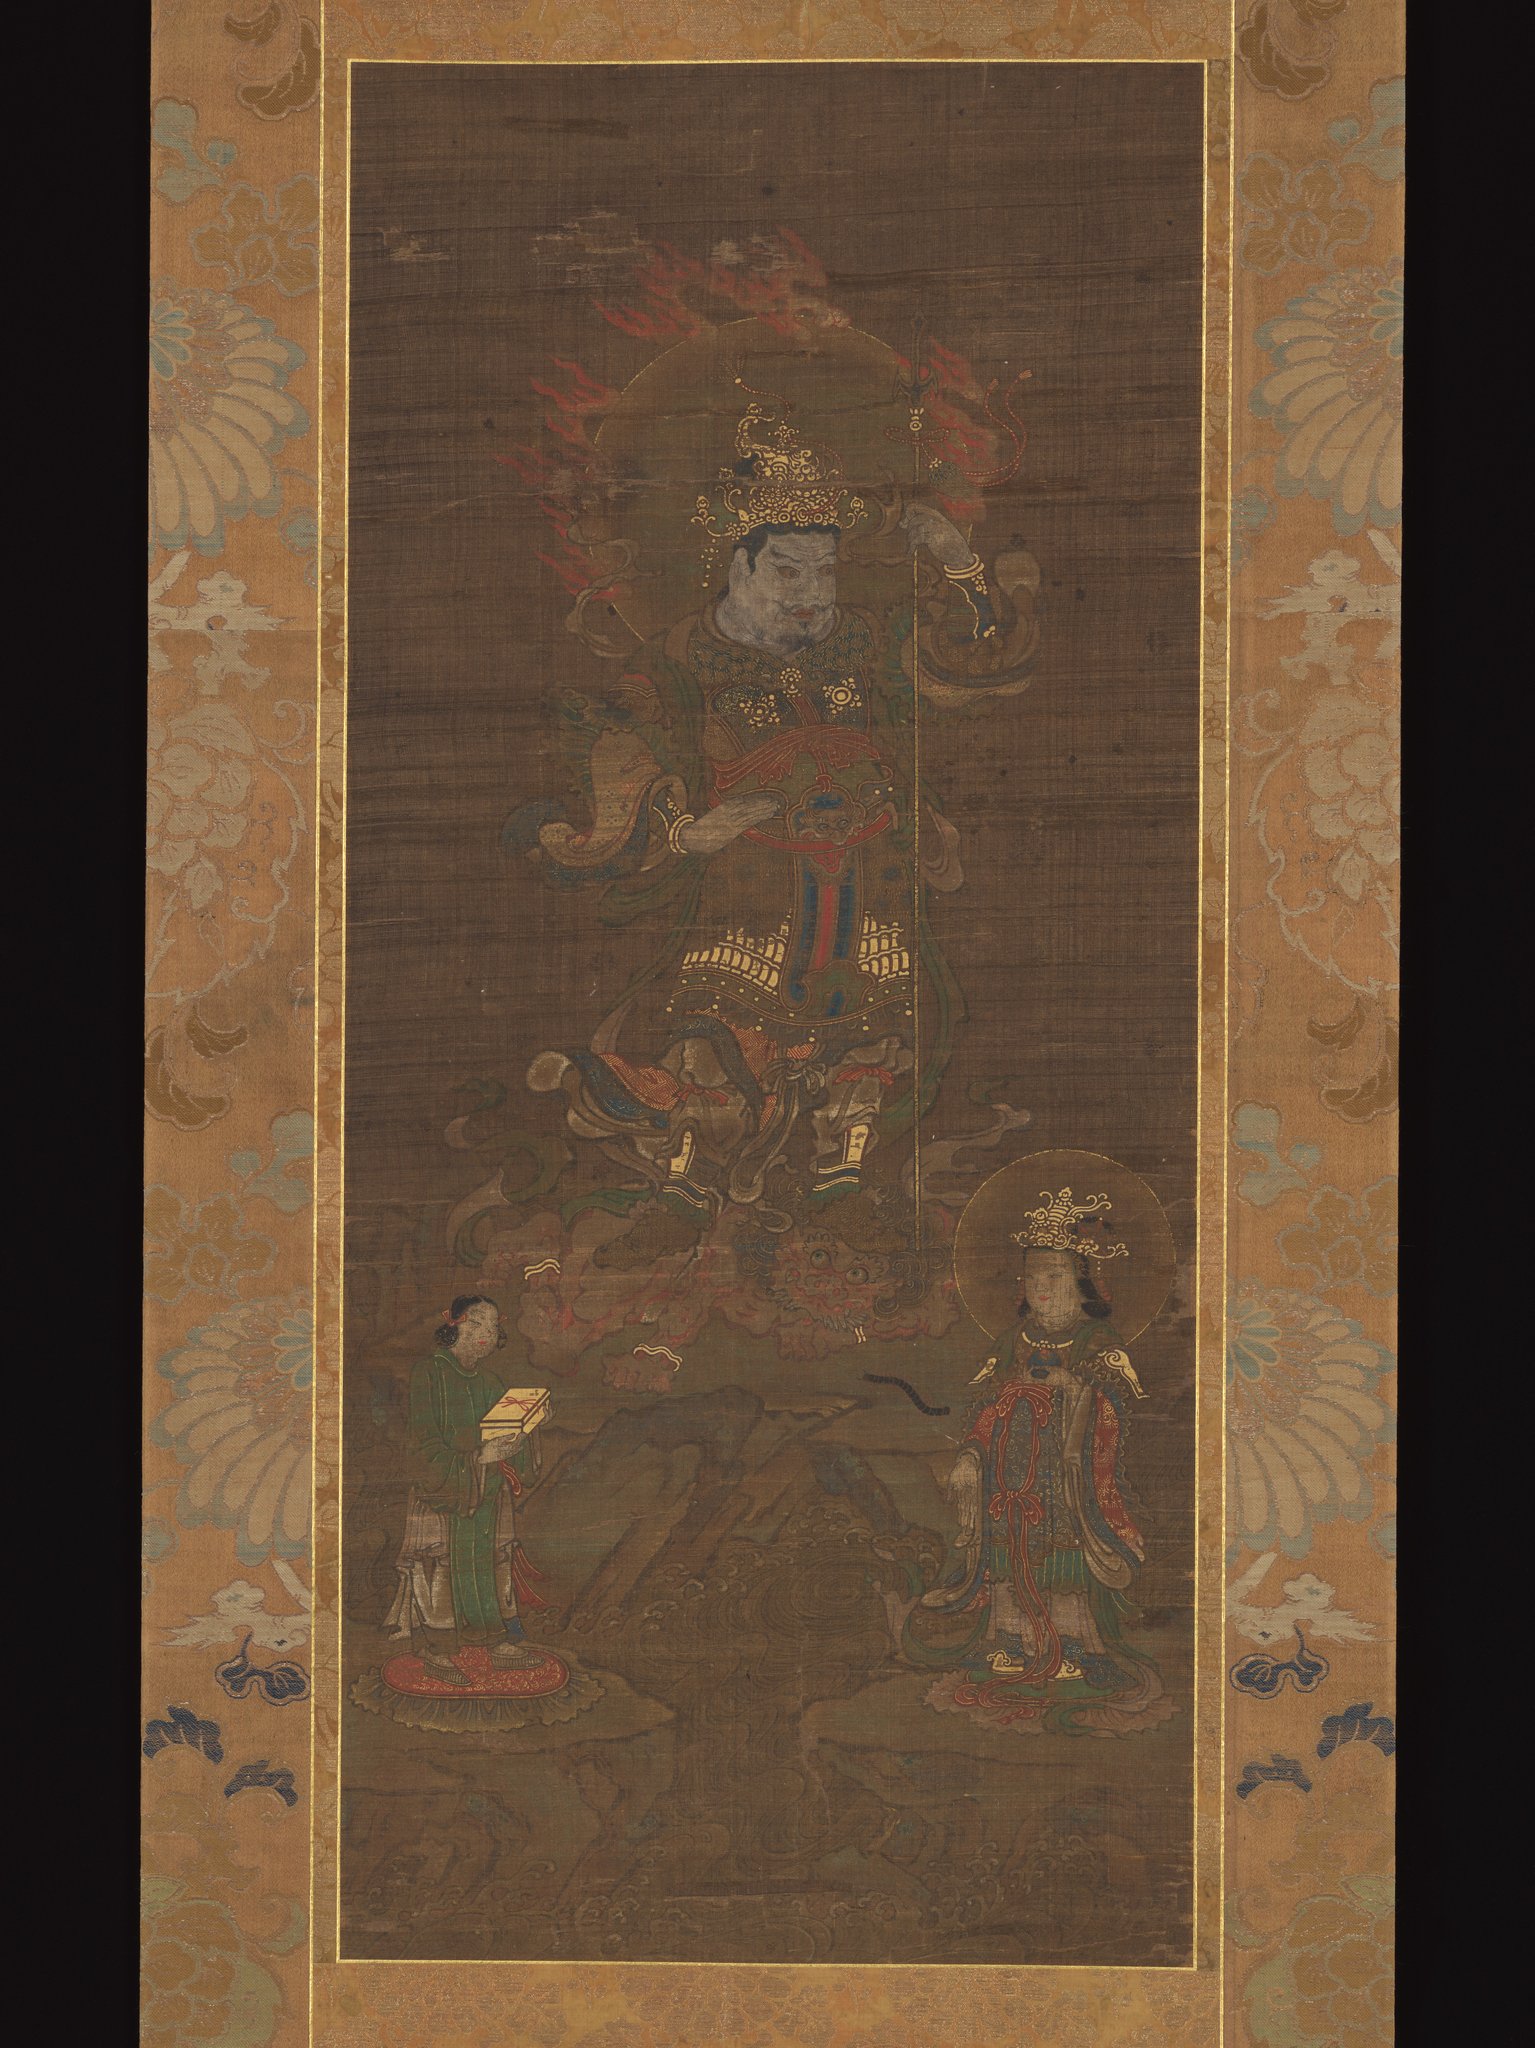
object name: hanging scroll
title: Mount Kurama Mandala: Bishamonten Triad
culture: japanese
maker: unidentified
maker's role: artist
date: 1401-1600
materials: gold, ink, silk